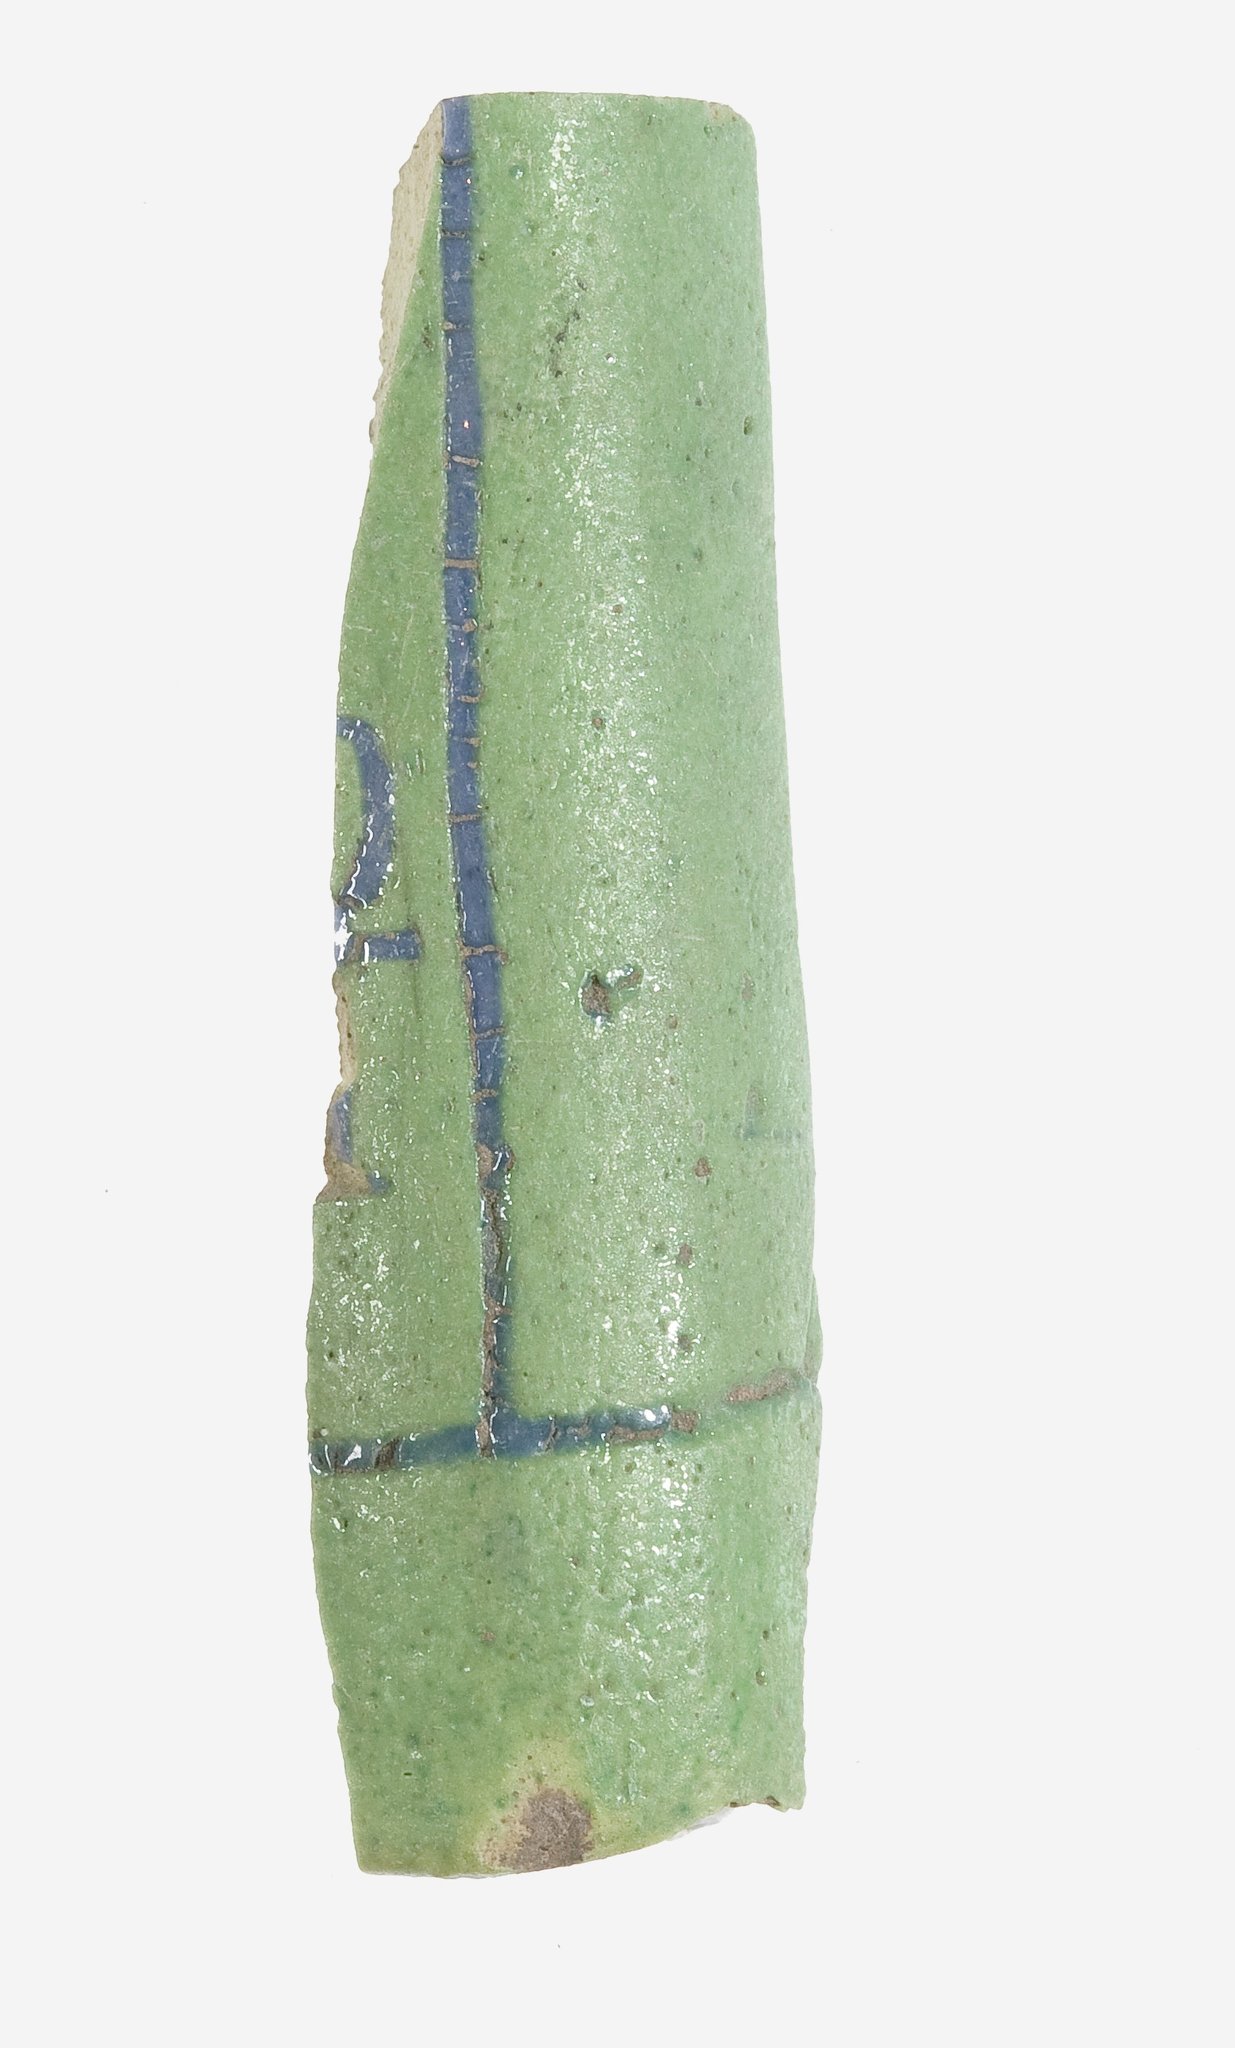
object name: kohl tube fragment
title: Fragment of Kohl Tube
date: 1390-1352 BCE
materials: faience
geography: egypt